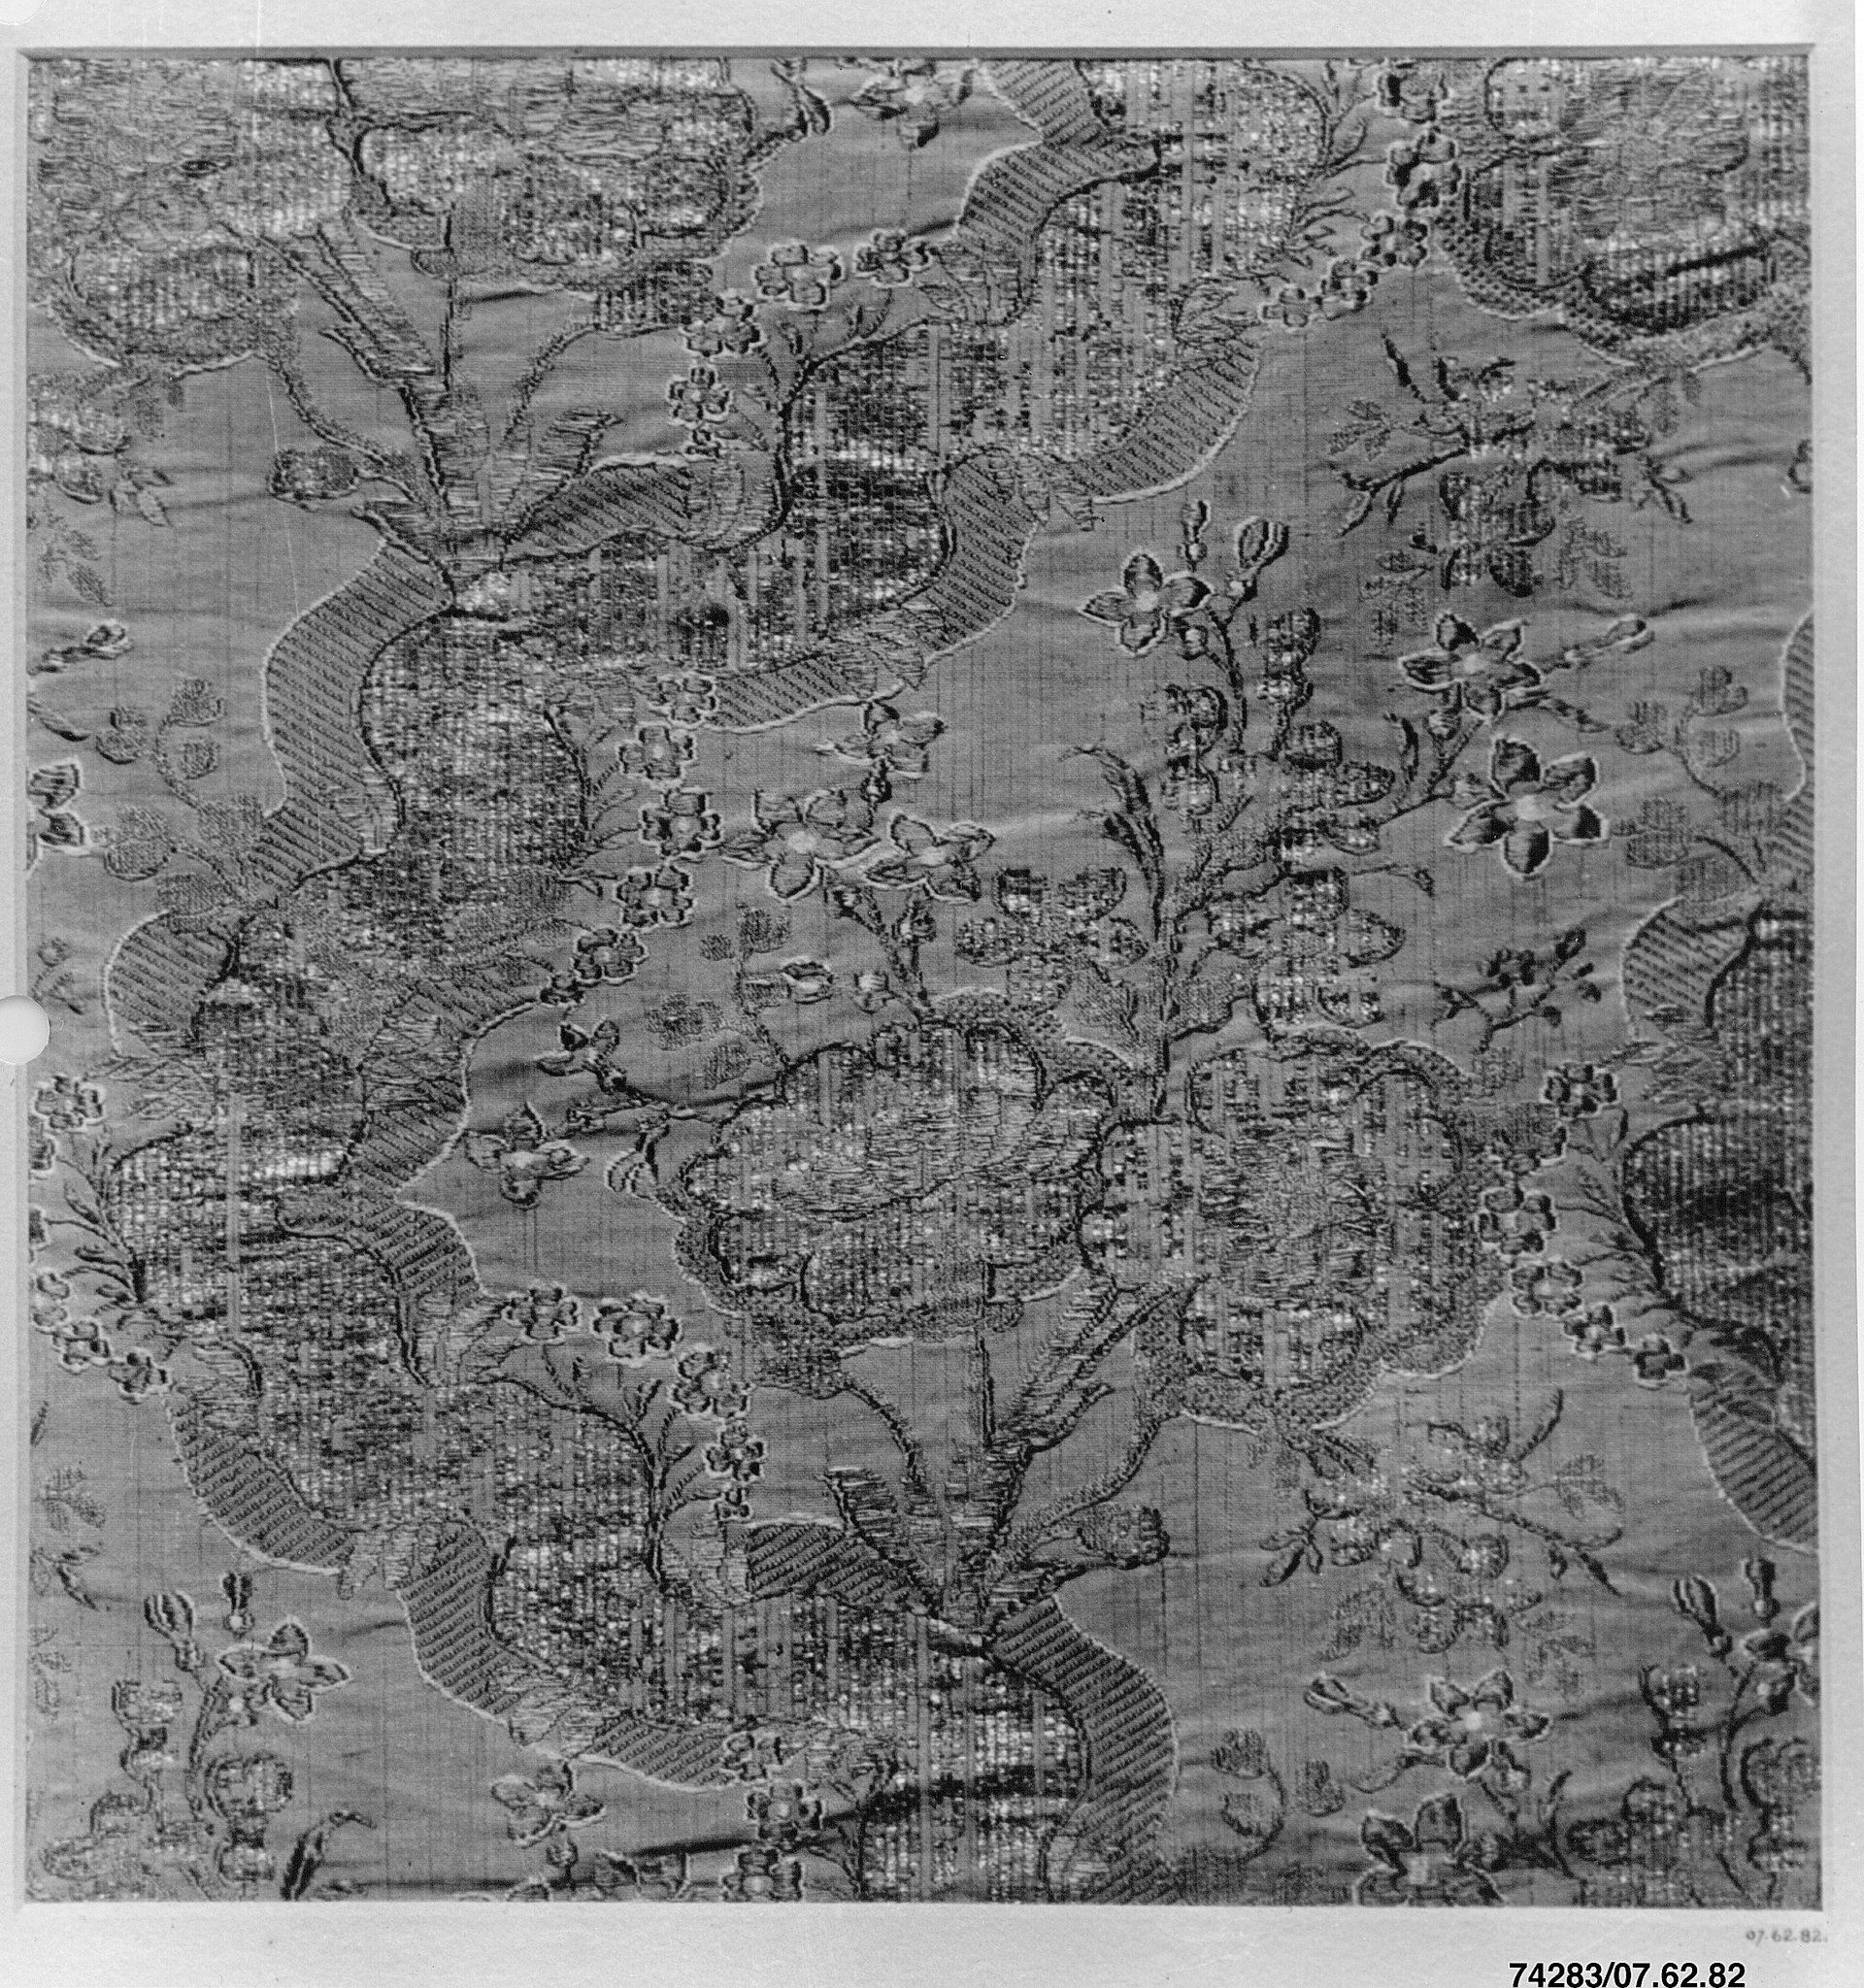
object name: piece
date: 1750-1760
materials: metal thread, silk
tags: flowers,plants